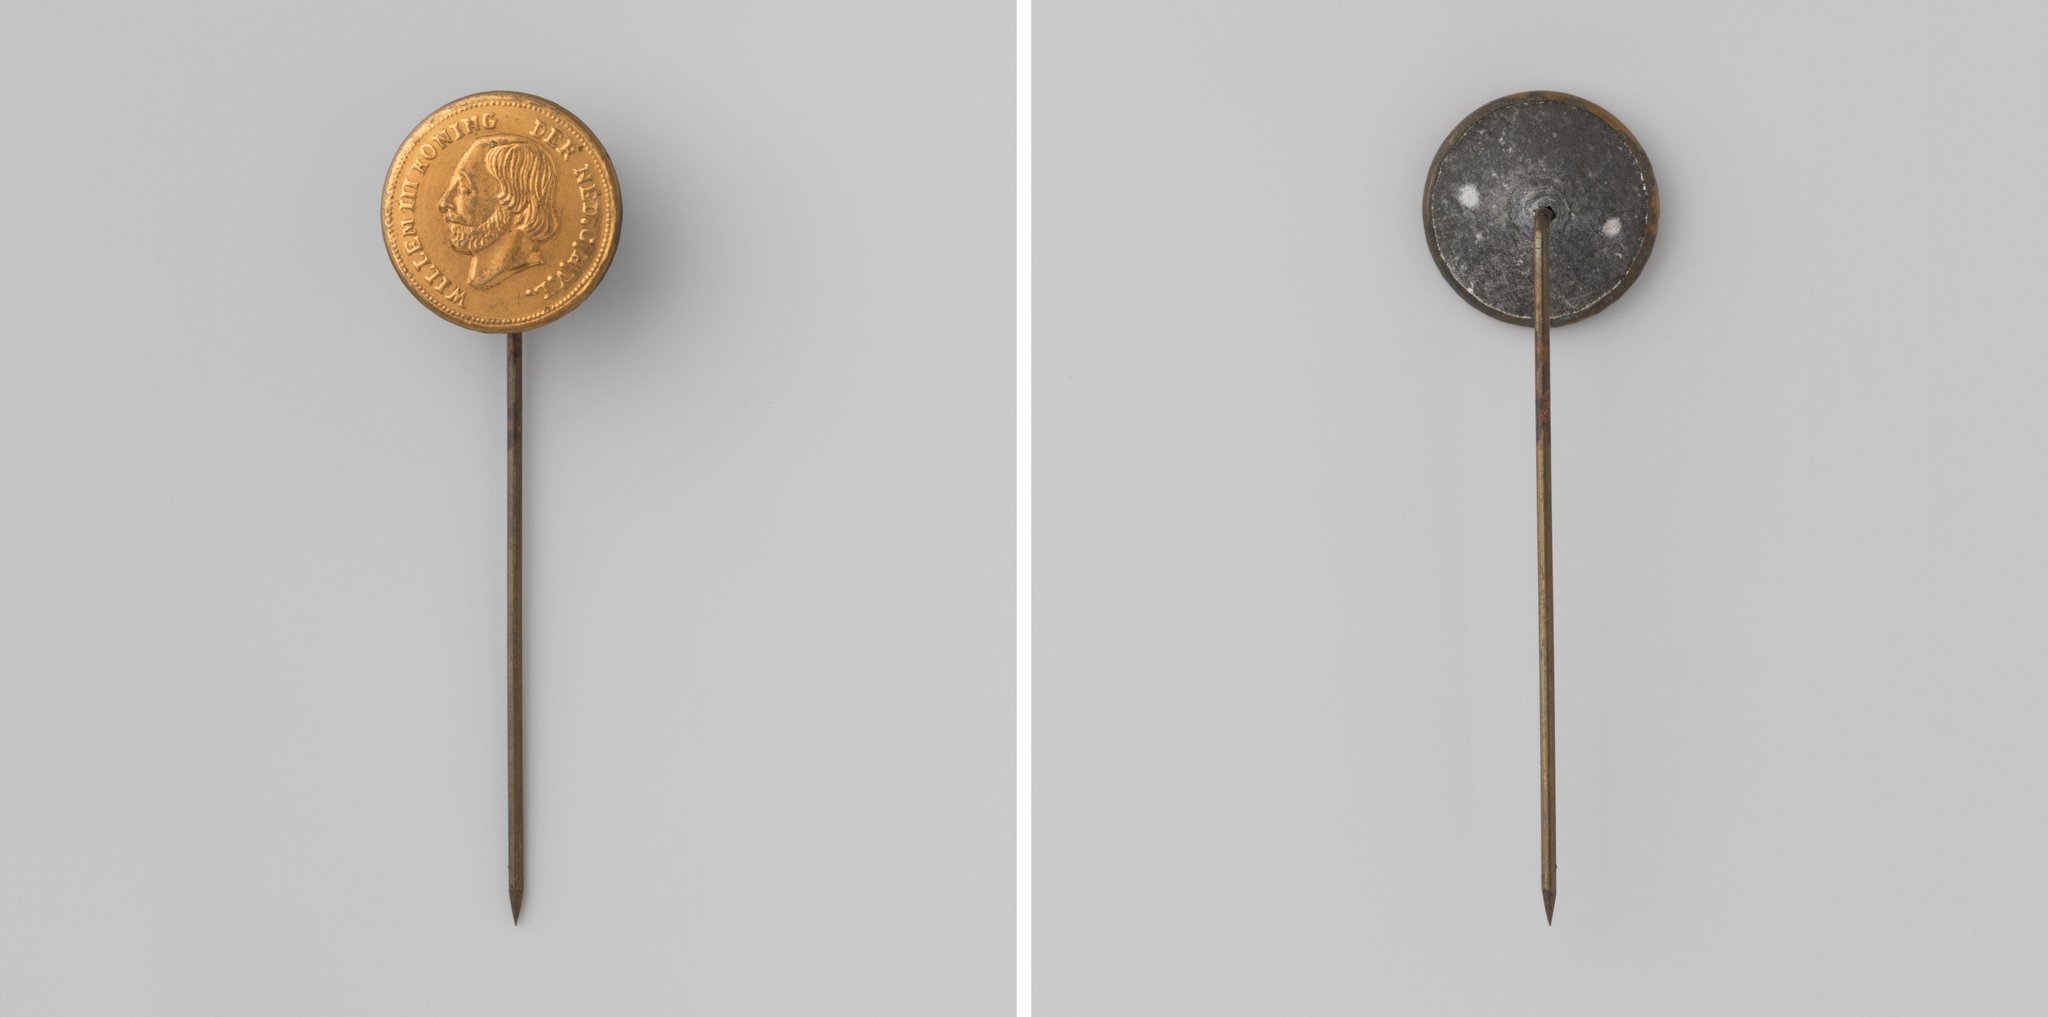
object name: history medal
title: Dasspeld op het vijfentwintigjarig regeringsjubileum van Koning Willem III 1874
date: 1860-1890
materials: brass, lead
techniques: pressing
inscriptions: circumscription: ‘WILLEM III KONING - DER NED. G.H.V.L.’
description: Speldje met rond muntvormig medaillon van verguld messing, waarop het portret van Willem III naar links met omschrift, met loden achterzijde.